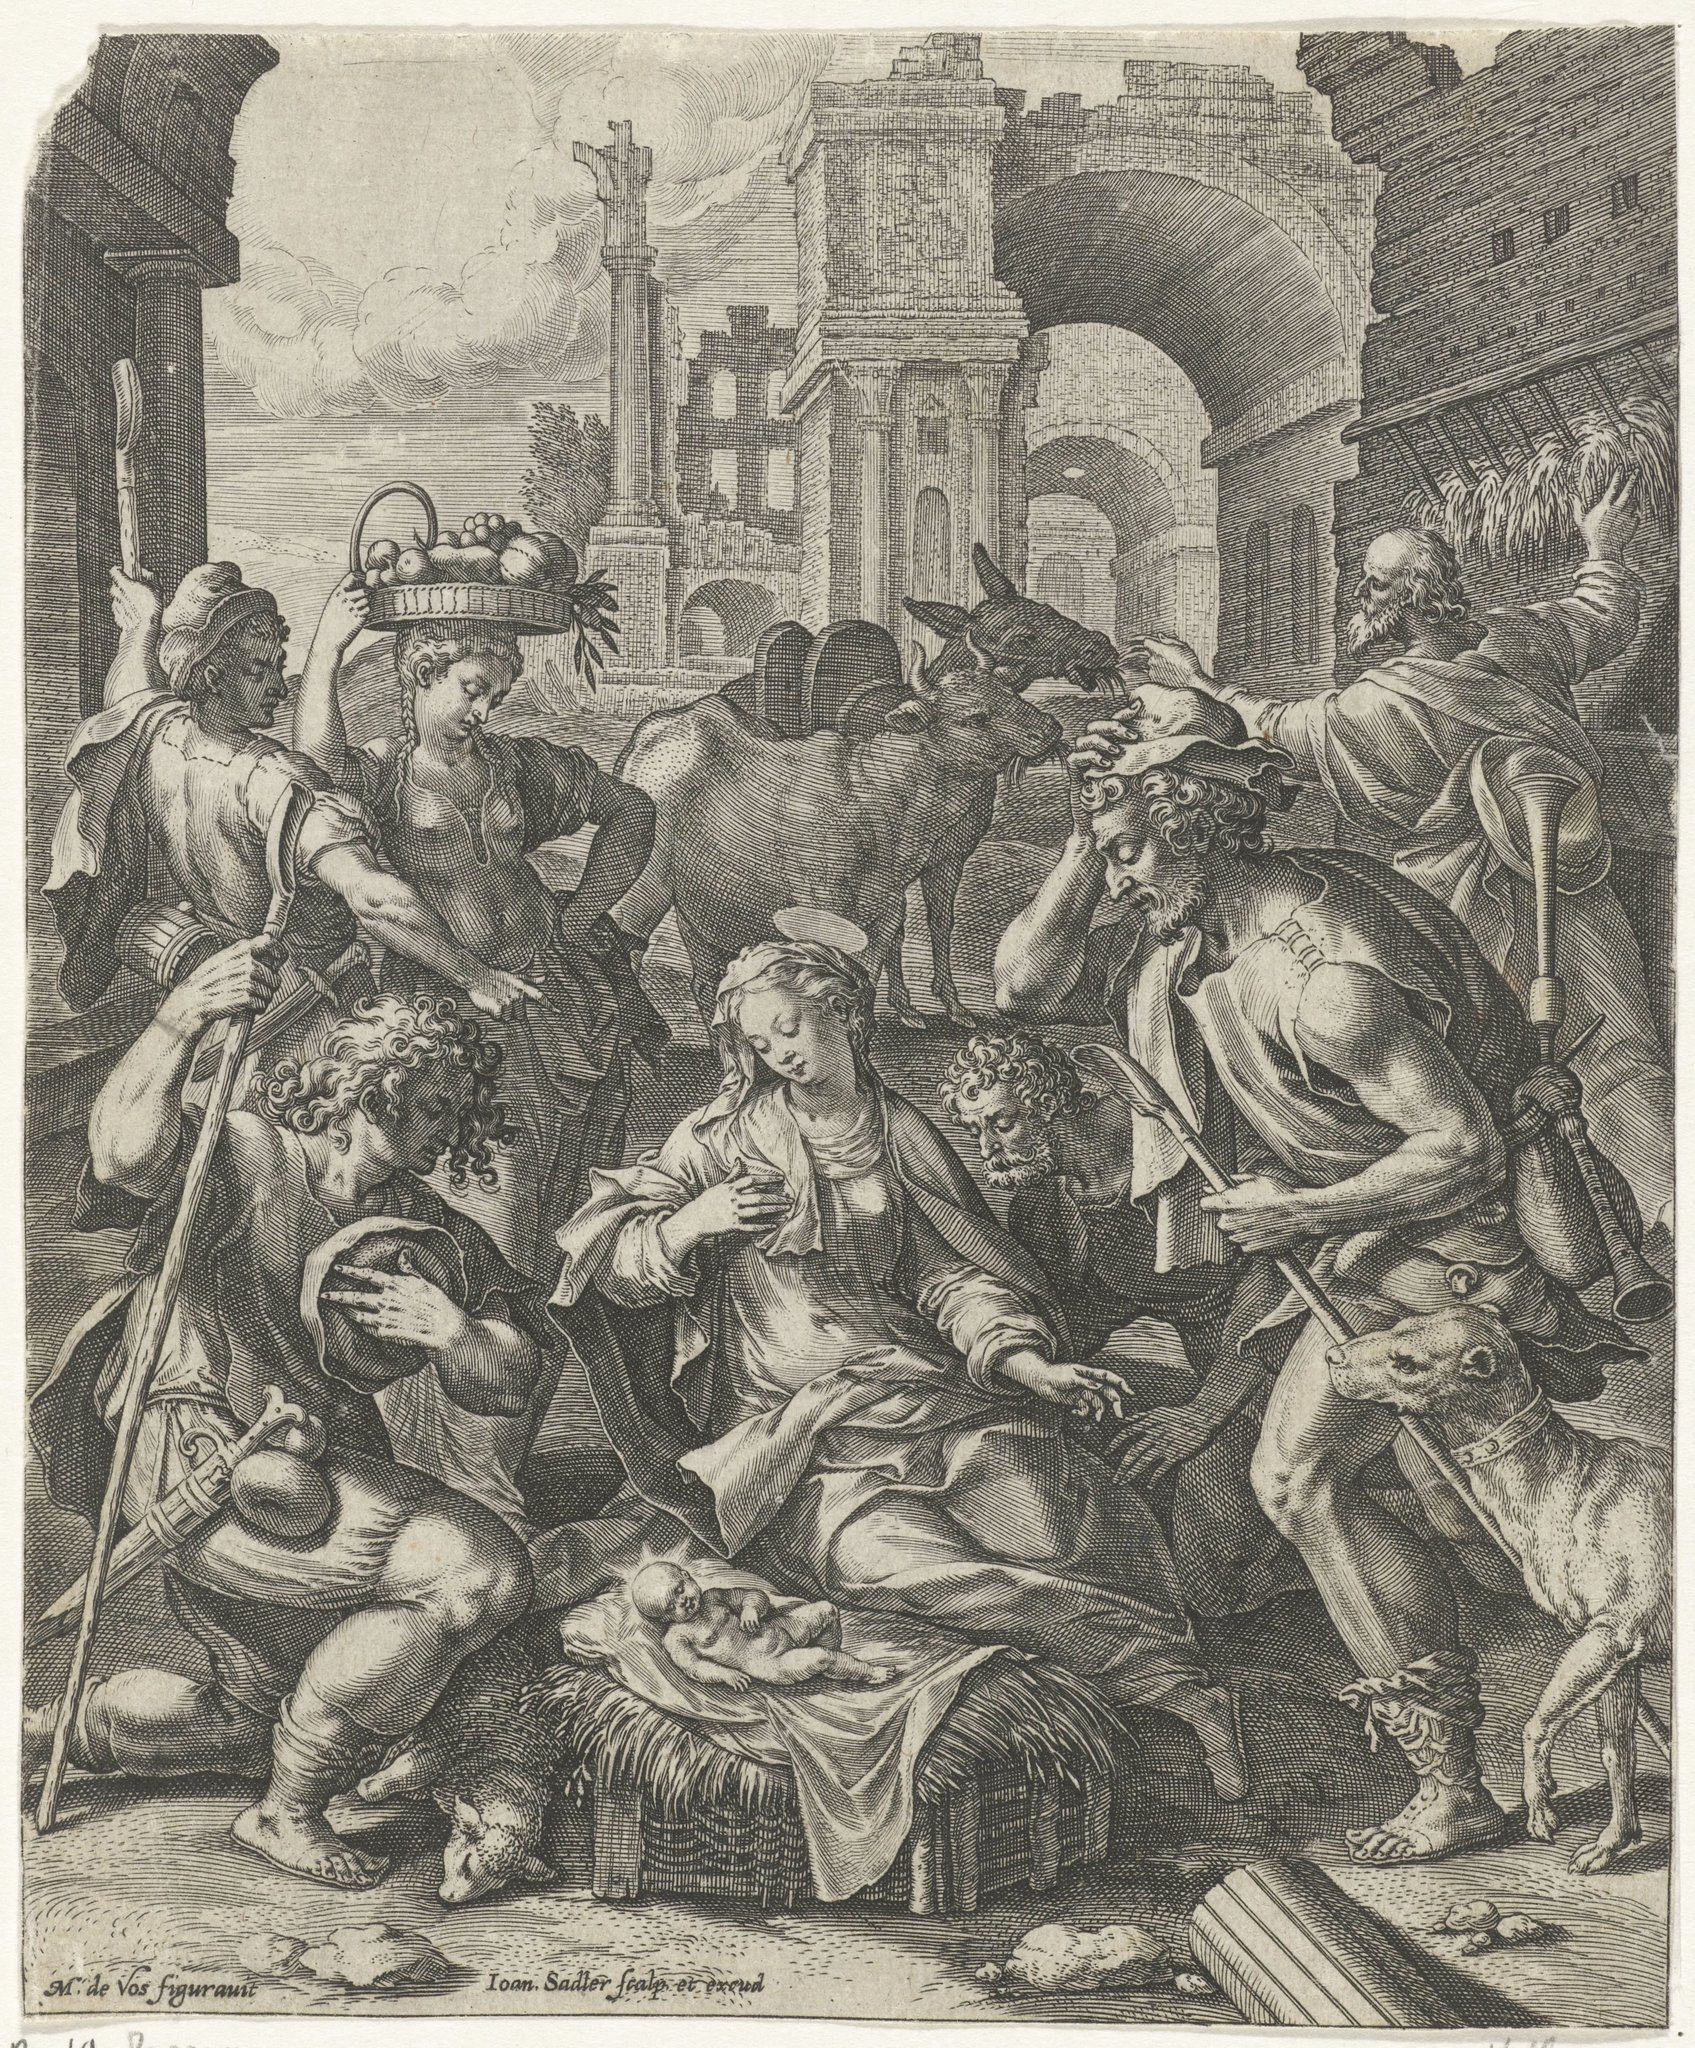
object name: print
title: Aanbidding door de herders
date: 1582-1584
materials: paper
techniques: engraving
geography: antwerp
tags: adoration of the christ-child by the shepherds; mary and joseph present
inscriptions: collector's mark: Lugt 2228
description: De herders bezoeken de stal en begroeten het Christuskind in de kribbe. Op de achtergrond een antieke ruïne. De prent maakt deel uit van een vijfdelige serie.